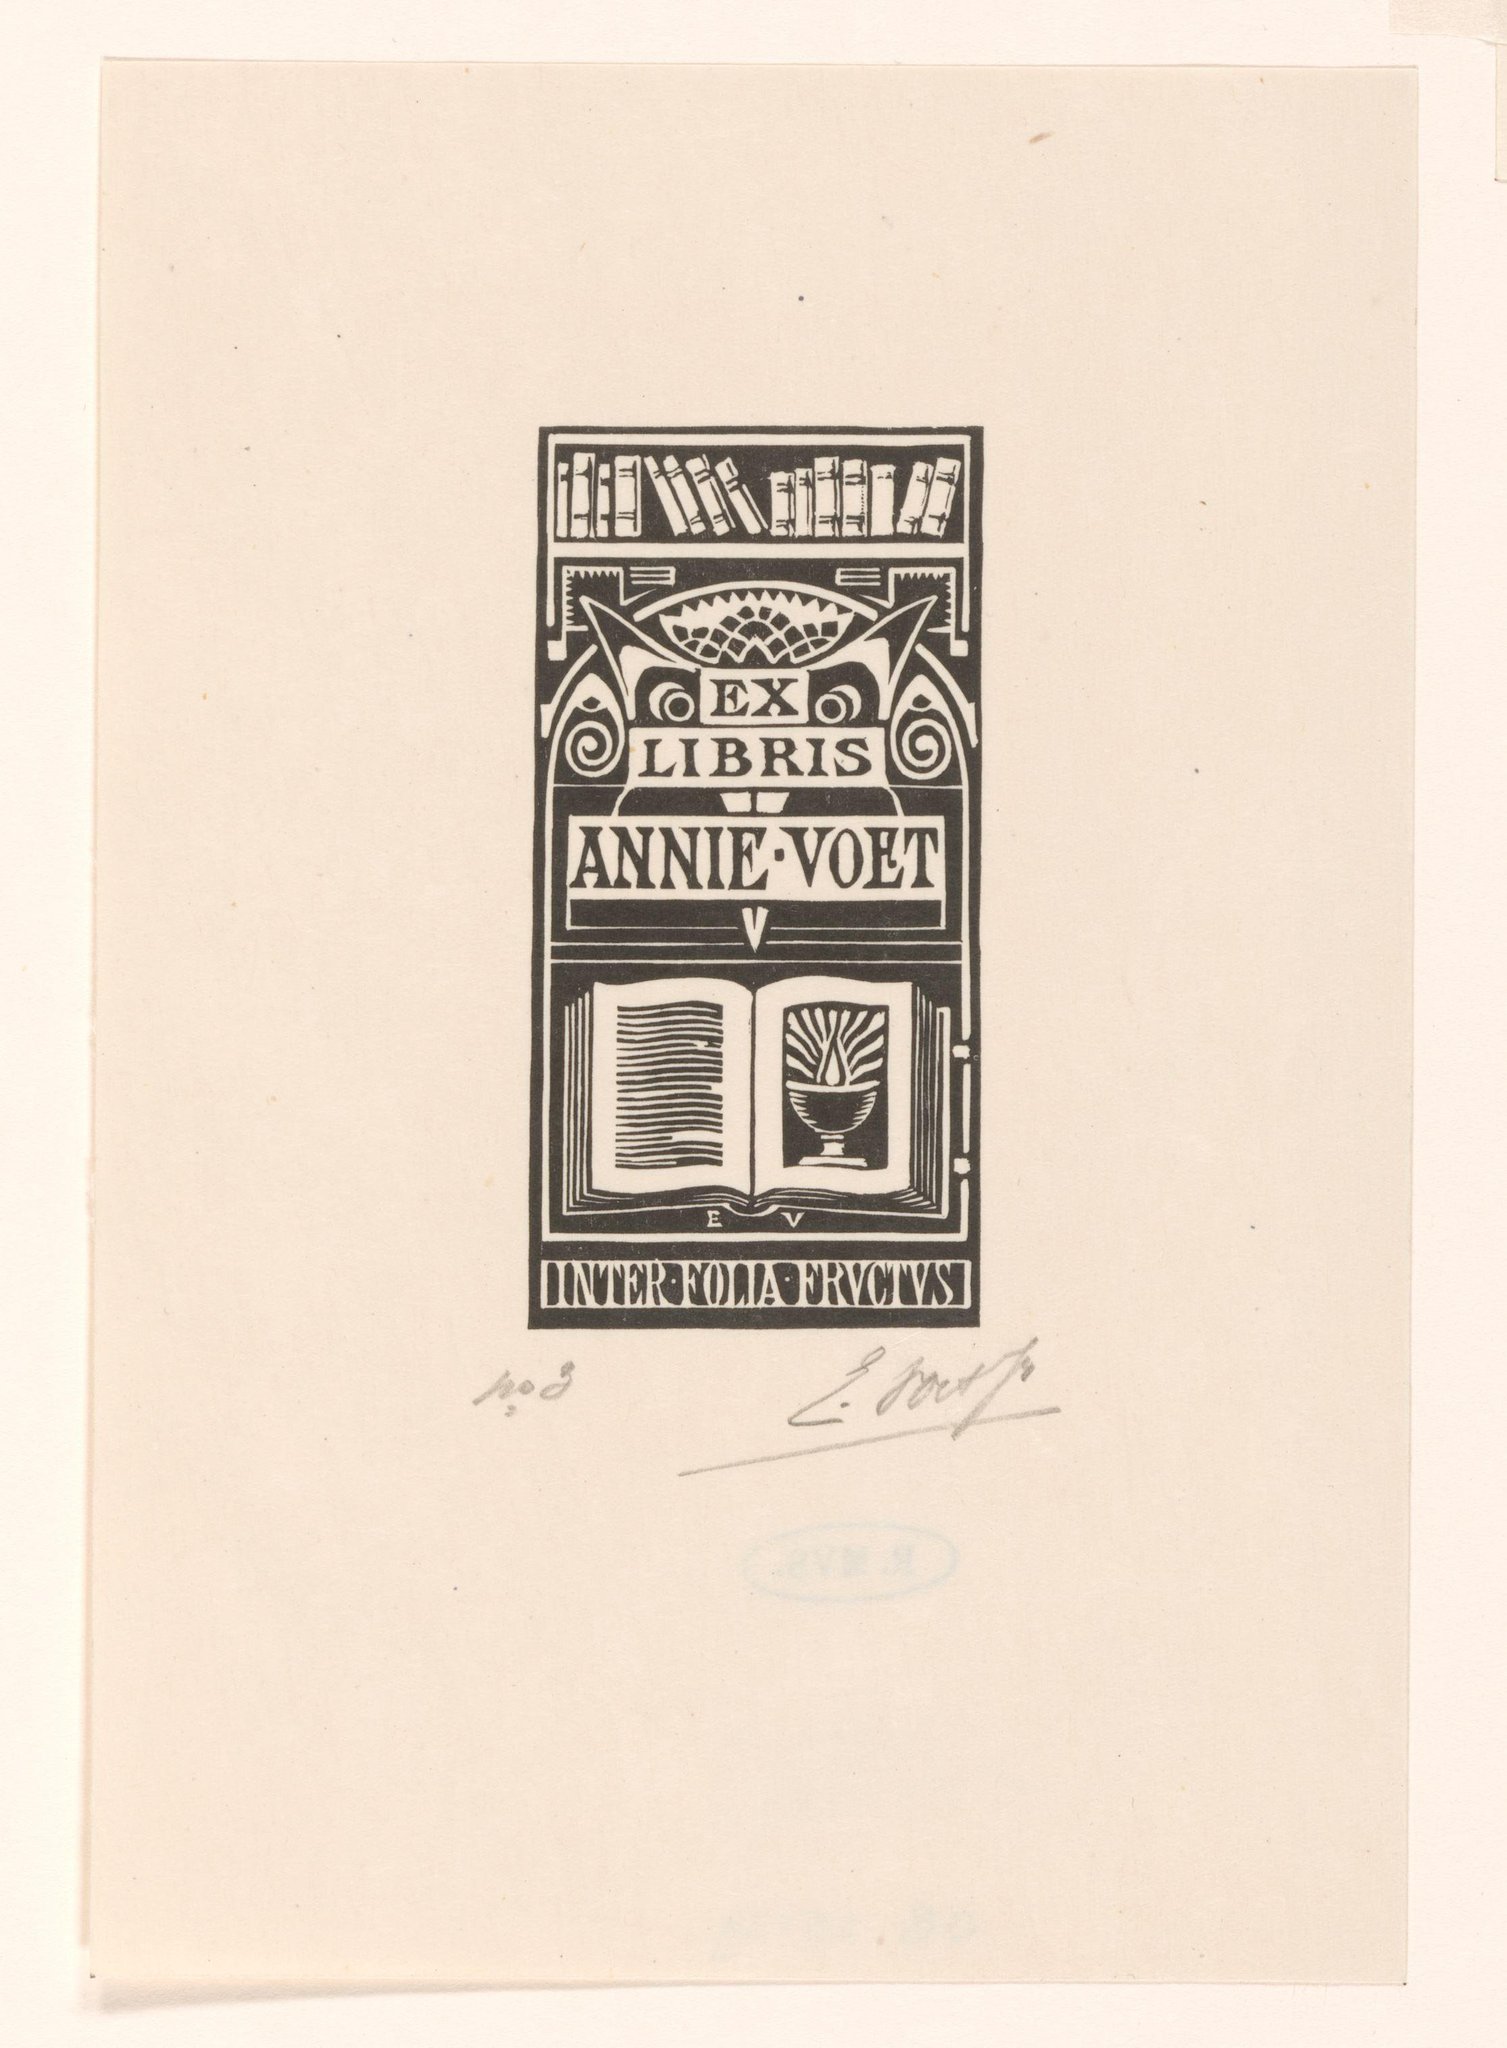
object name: bookplate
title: Ex libris van Annie Voet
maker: elias voet jr.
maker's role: jeweler, print maker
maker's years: 1868-1940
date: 1878-1940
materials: paper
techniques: woodcut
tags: book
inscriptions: collector's mark: Lugt 2228